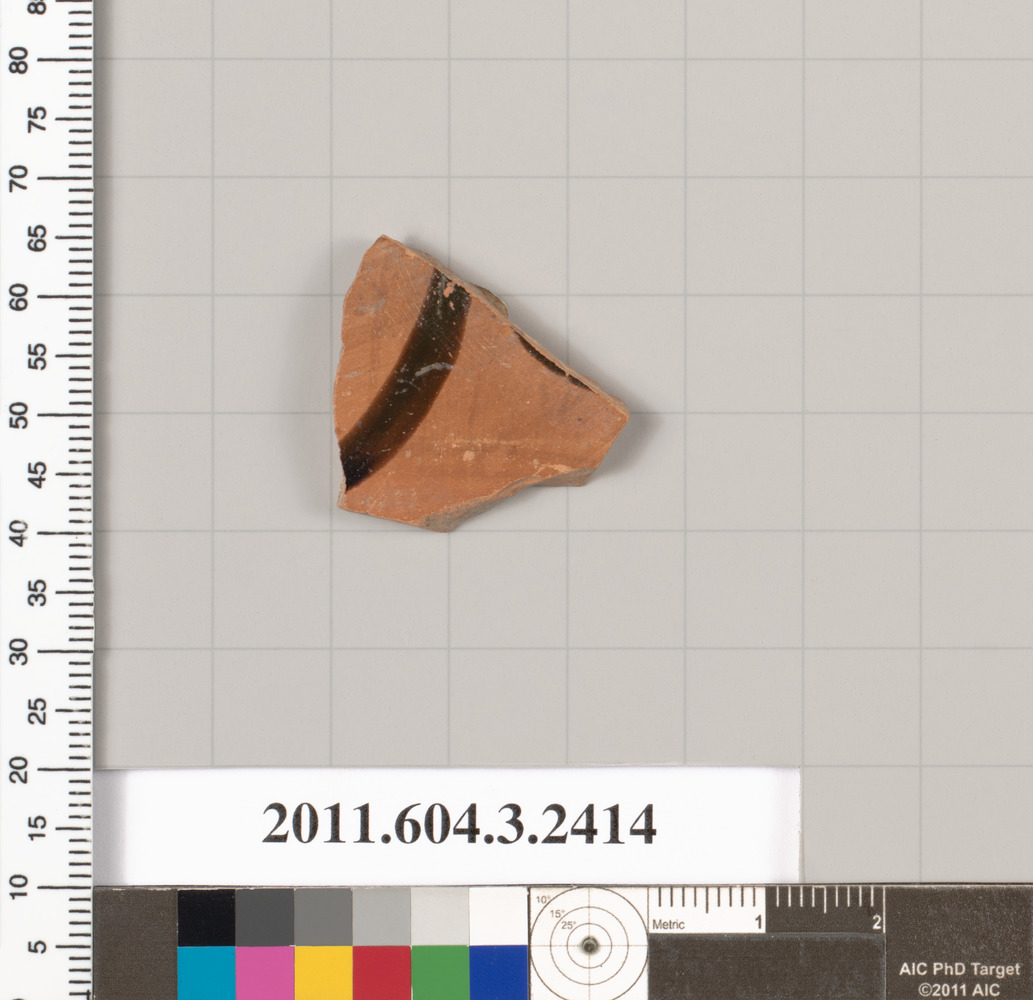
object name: kylix fragment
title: Terracotta fragment of a kylix: eye-cup (drinking cup)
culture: greek, attic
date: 530-510 BCE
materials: terracotta